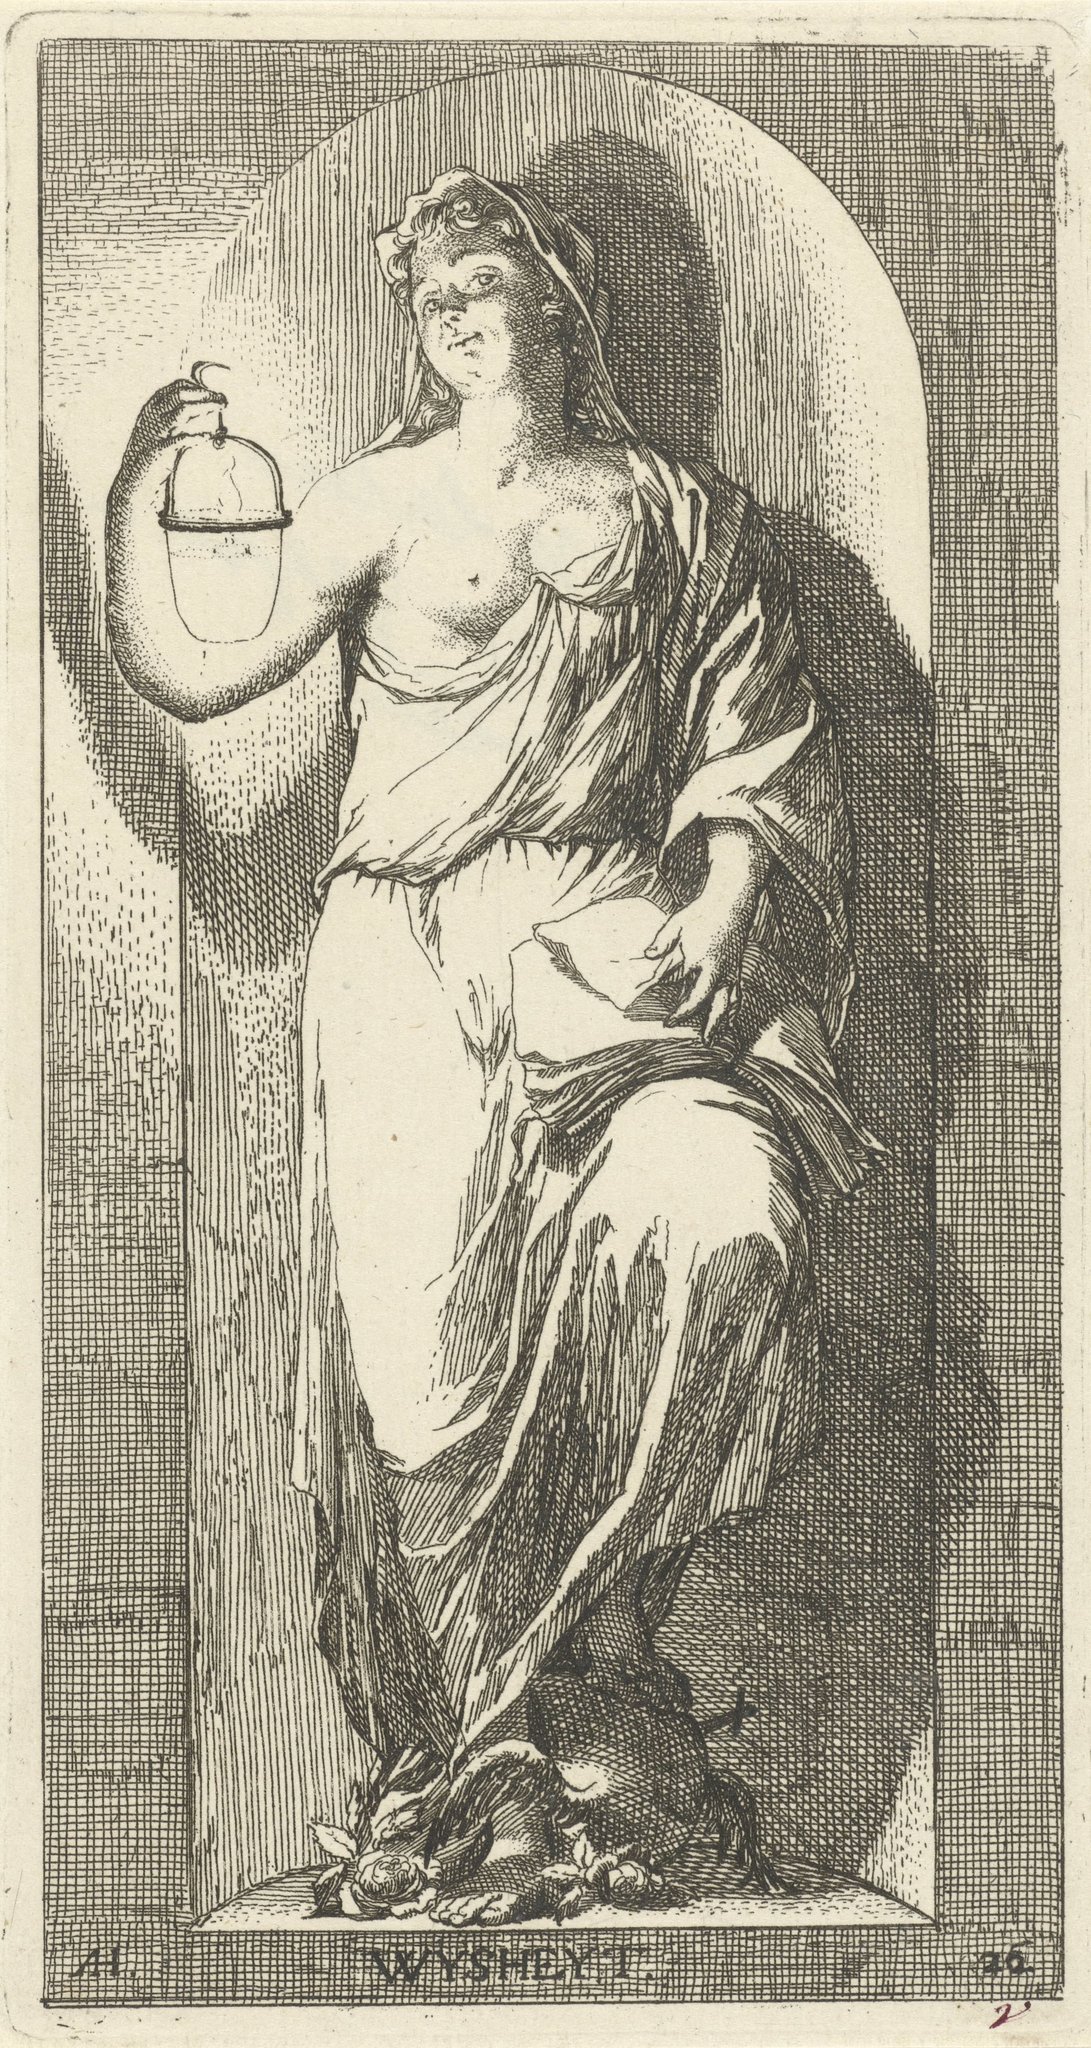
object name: print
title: Personificatie van de wijsheid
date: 1710-1719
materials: paper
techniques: etching, pen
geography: amsterdam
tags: wisdom; 'sapienza', 'sapienza humana', 'sapienza vera' (ripa), darkness, lantern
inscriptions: inscription: ‘v’, collector's mark: Lugt 2228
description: Een vrouwfiguur als personificatie van de wijheid met een lantaarn in een nis. Prent uit een serie van 41 zinnebeelden.